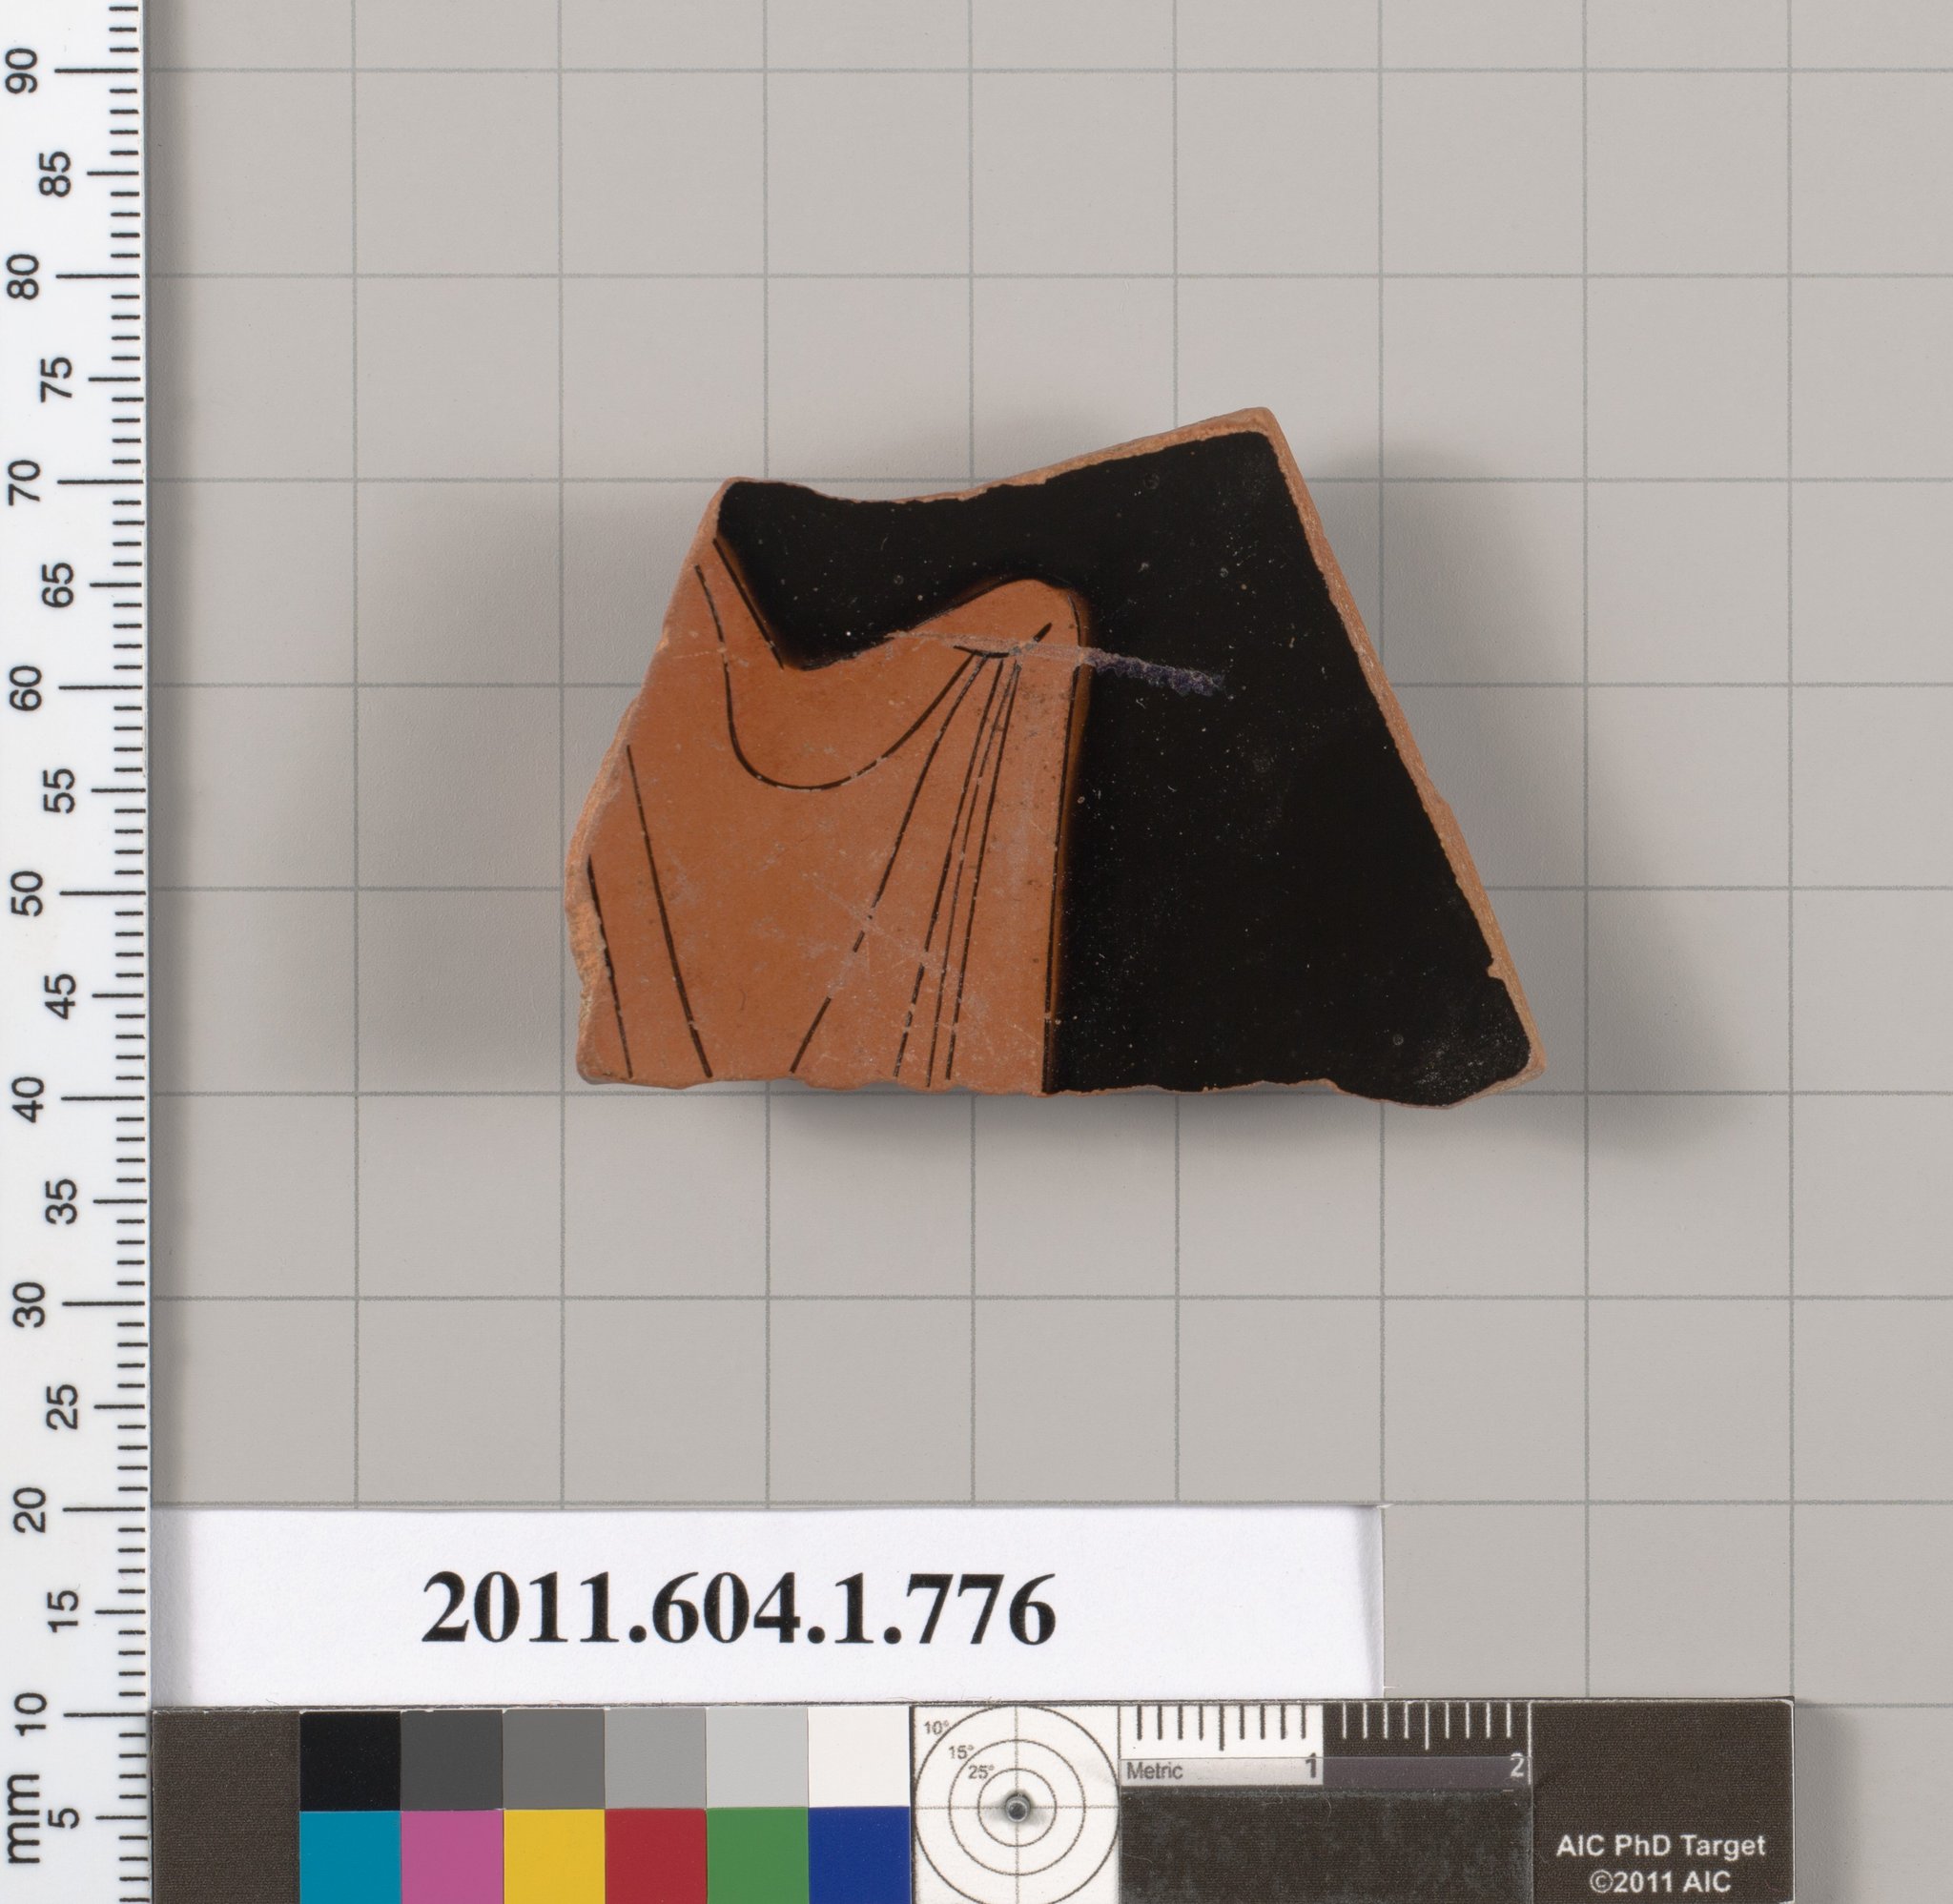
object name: kylix fragment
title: Terracotta fragment of a kylix (drinking cup)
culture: greek, attic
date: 475-451 BCE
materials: terracotta